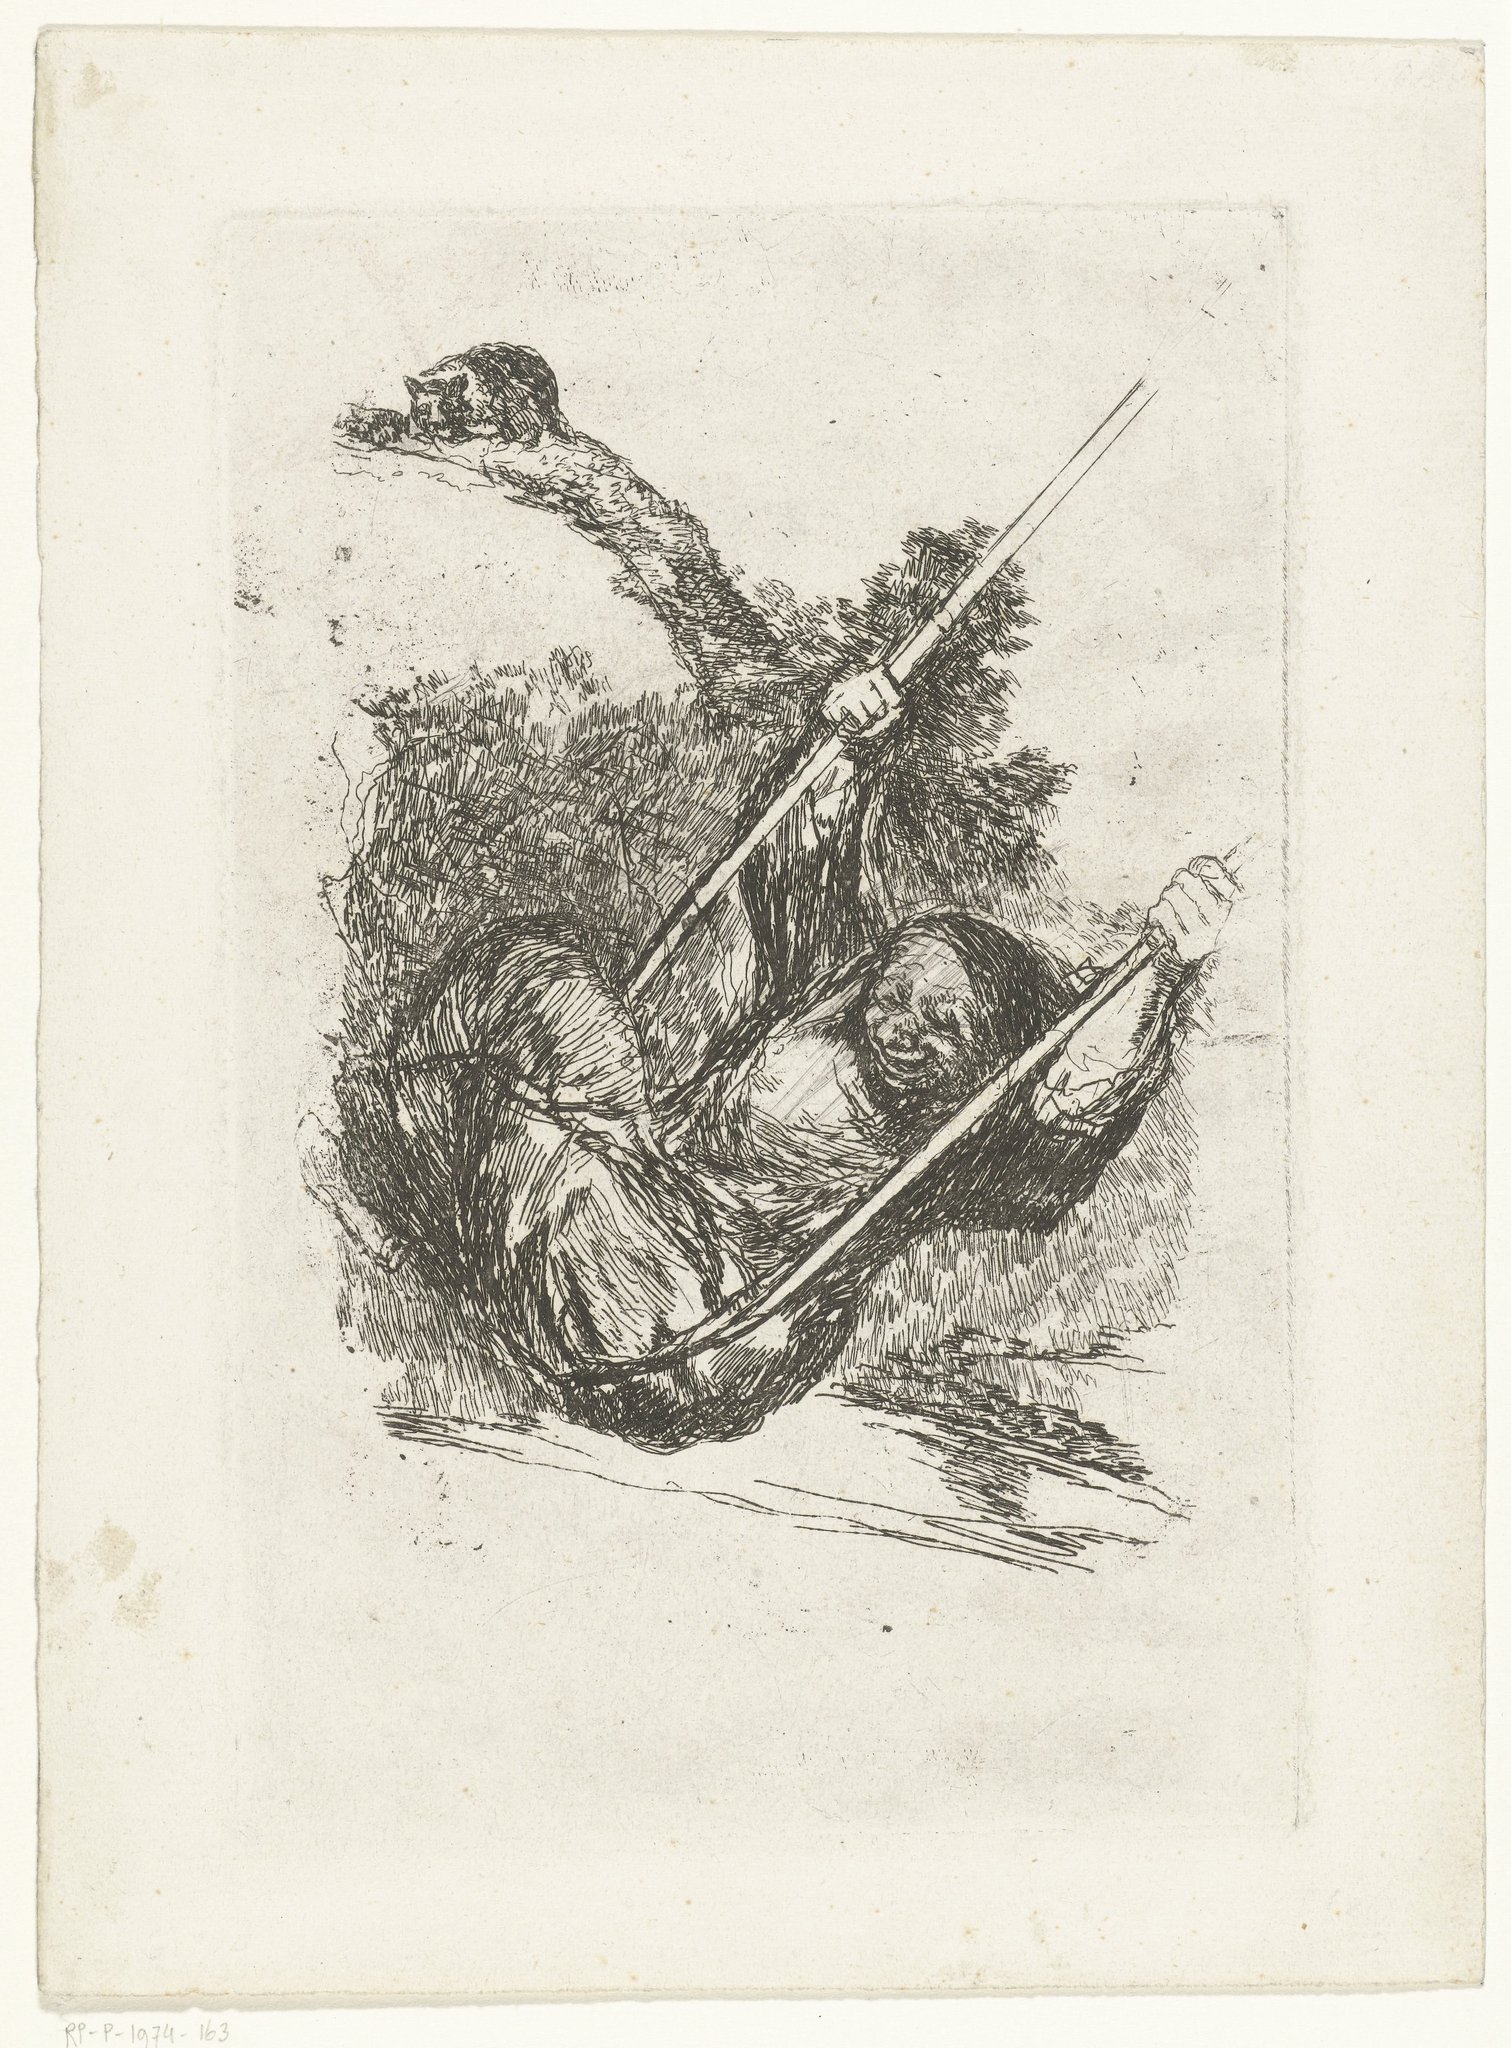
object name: print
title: Vieja columpiándose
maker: francisco de goya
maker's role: draughtsman, painter, print maker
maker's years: 1746-1828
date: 1824-1828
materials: paper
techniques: etching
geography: bordeaux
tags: old woman, swinging (children's game), swing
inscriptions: collector's mark: Lugt 2228, collector's mark: Lugt 1975, collector's mark: ‘ZB’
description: Een oude vrouw op een schommel. Op de tak van een boom een kat.